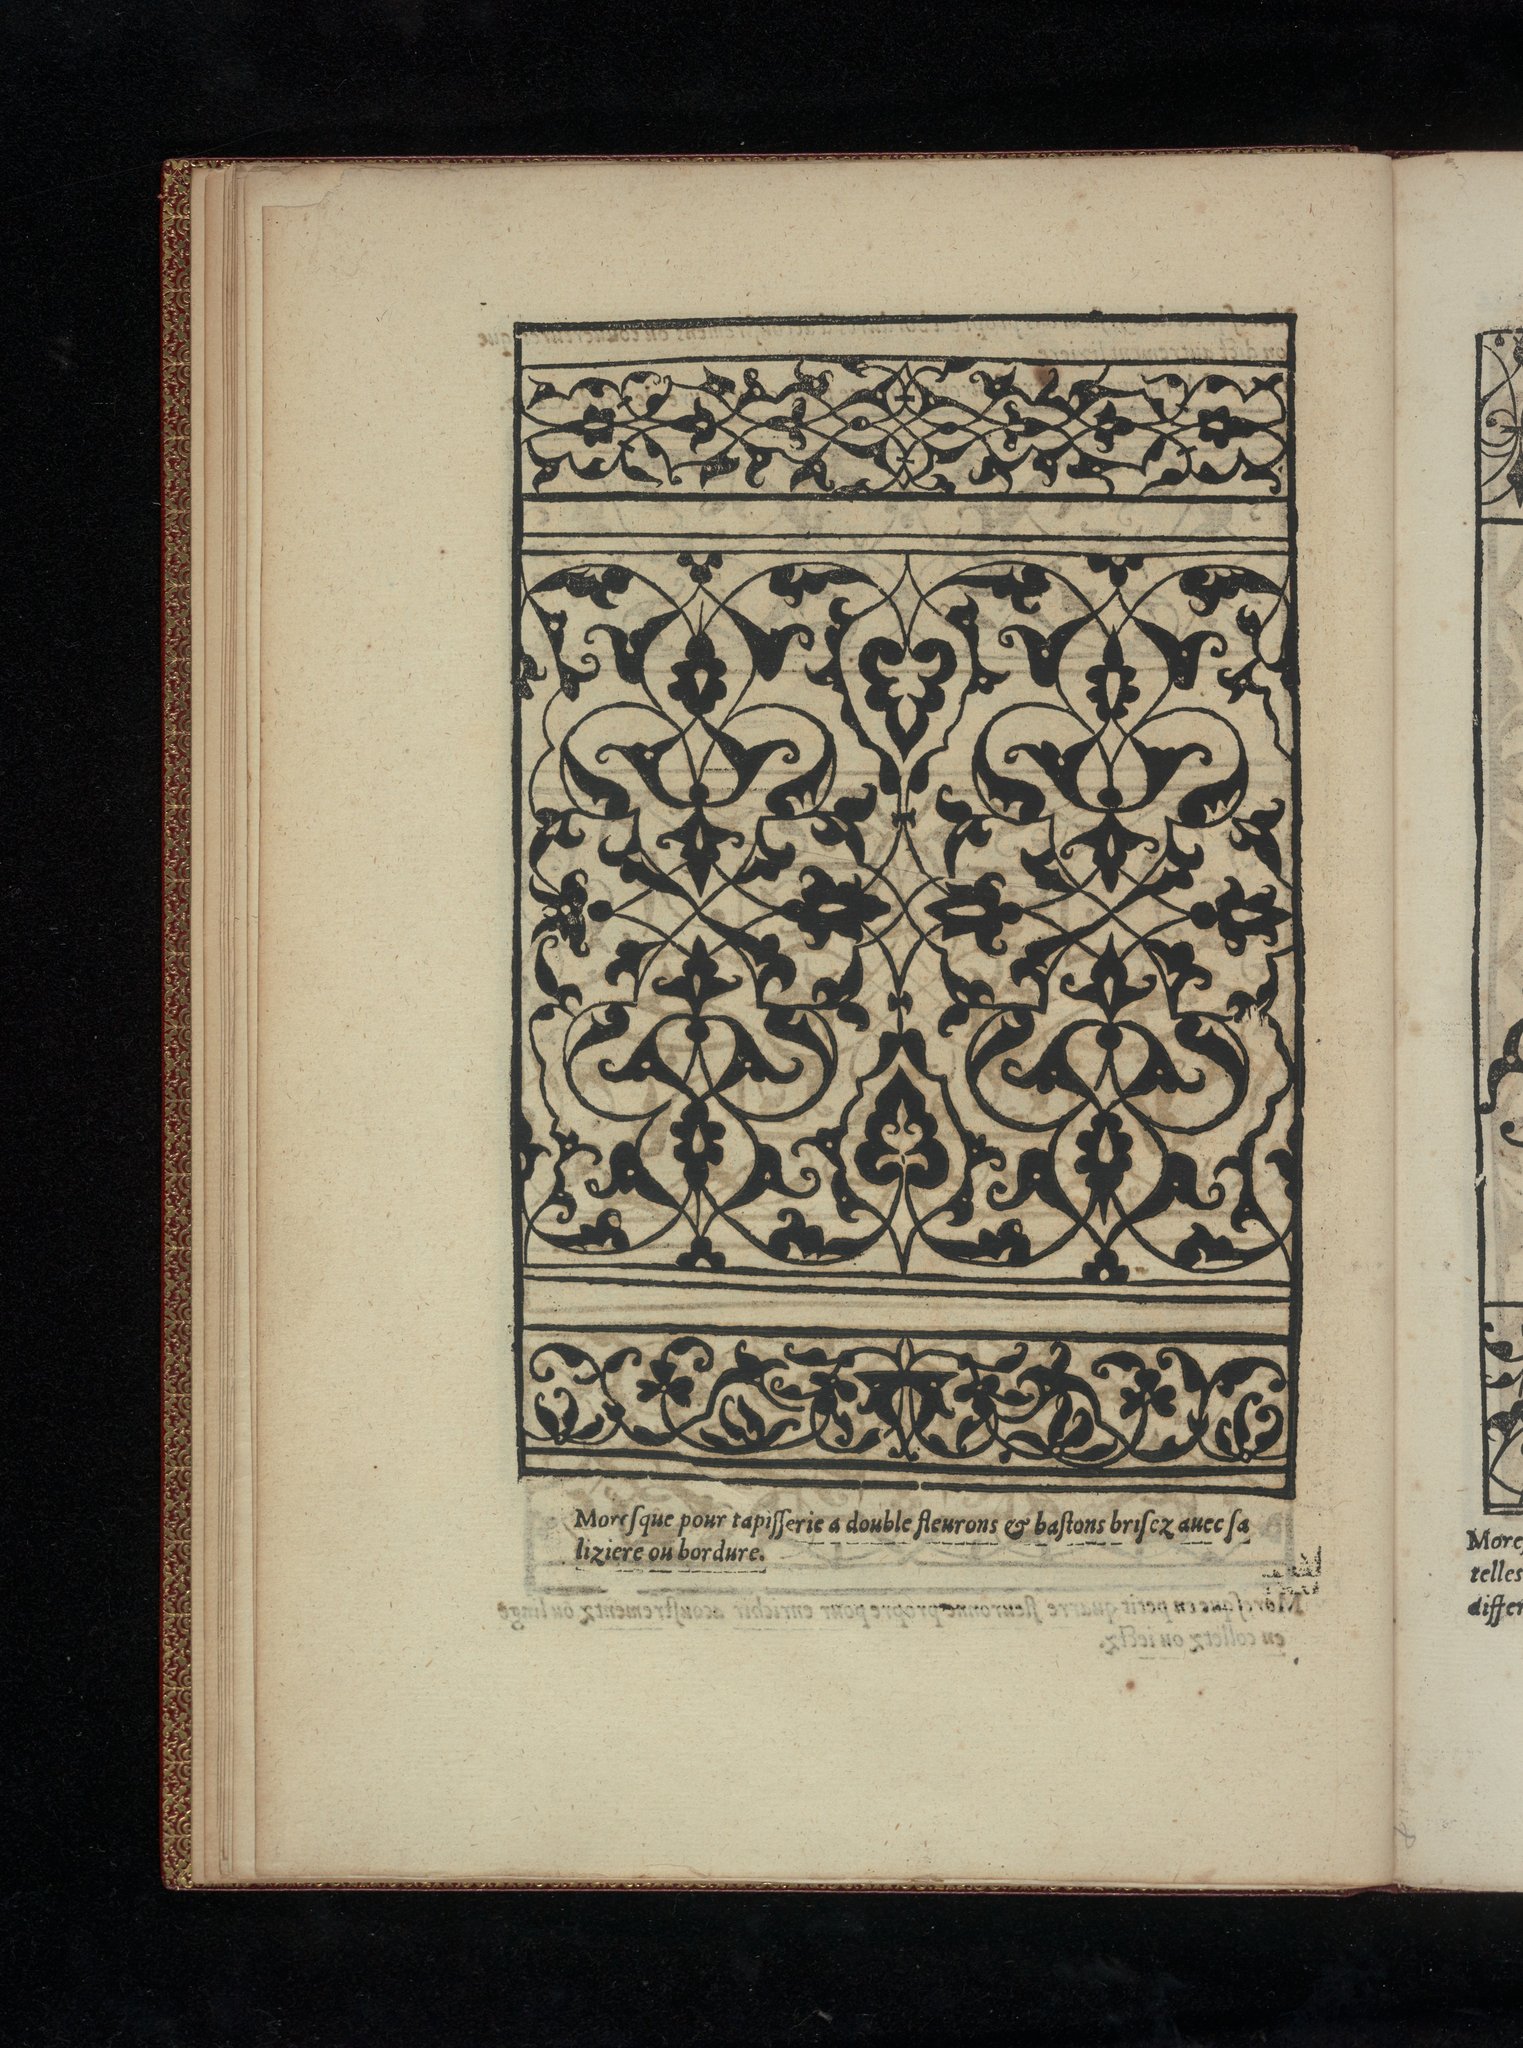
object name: book print ornament architecture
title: Livre de Moresques, page 5 (recto)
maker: francesco di pellegrino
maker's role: artist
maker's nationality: italian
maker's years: 1525-1552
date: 1546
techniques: woodcut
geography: france